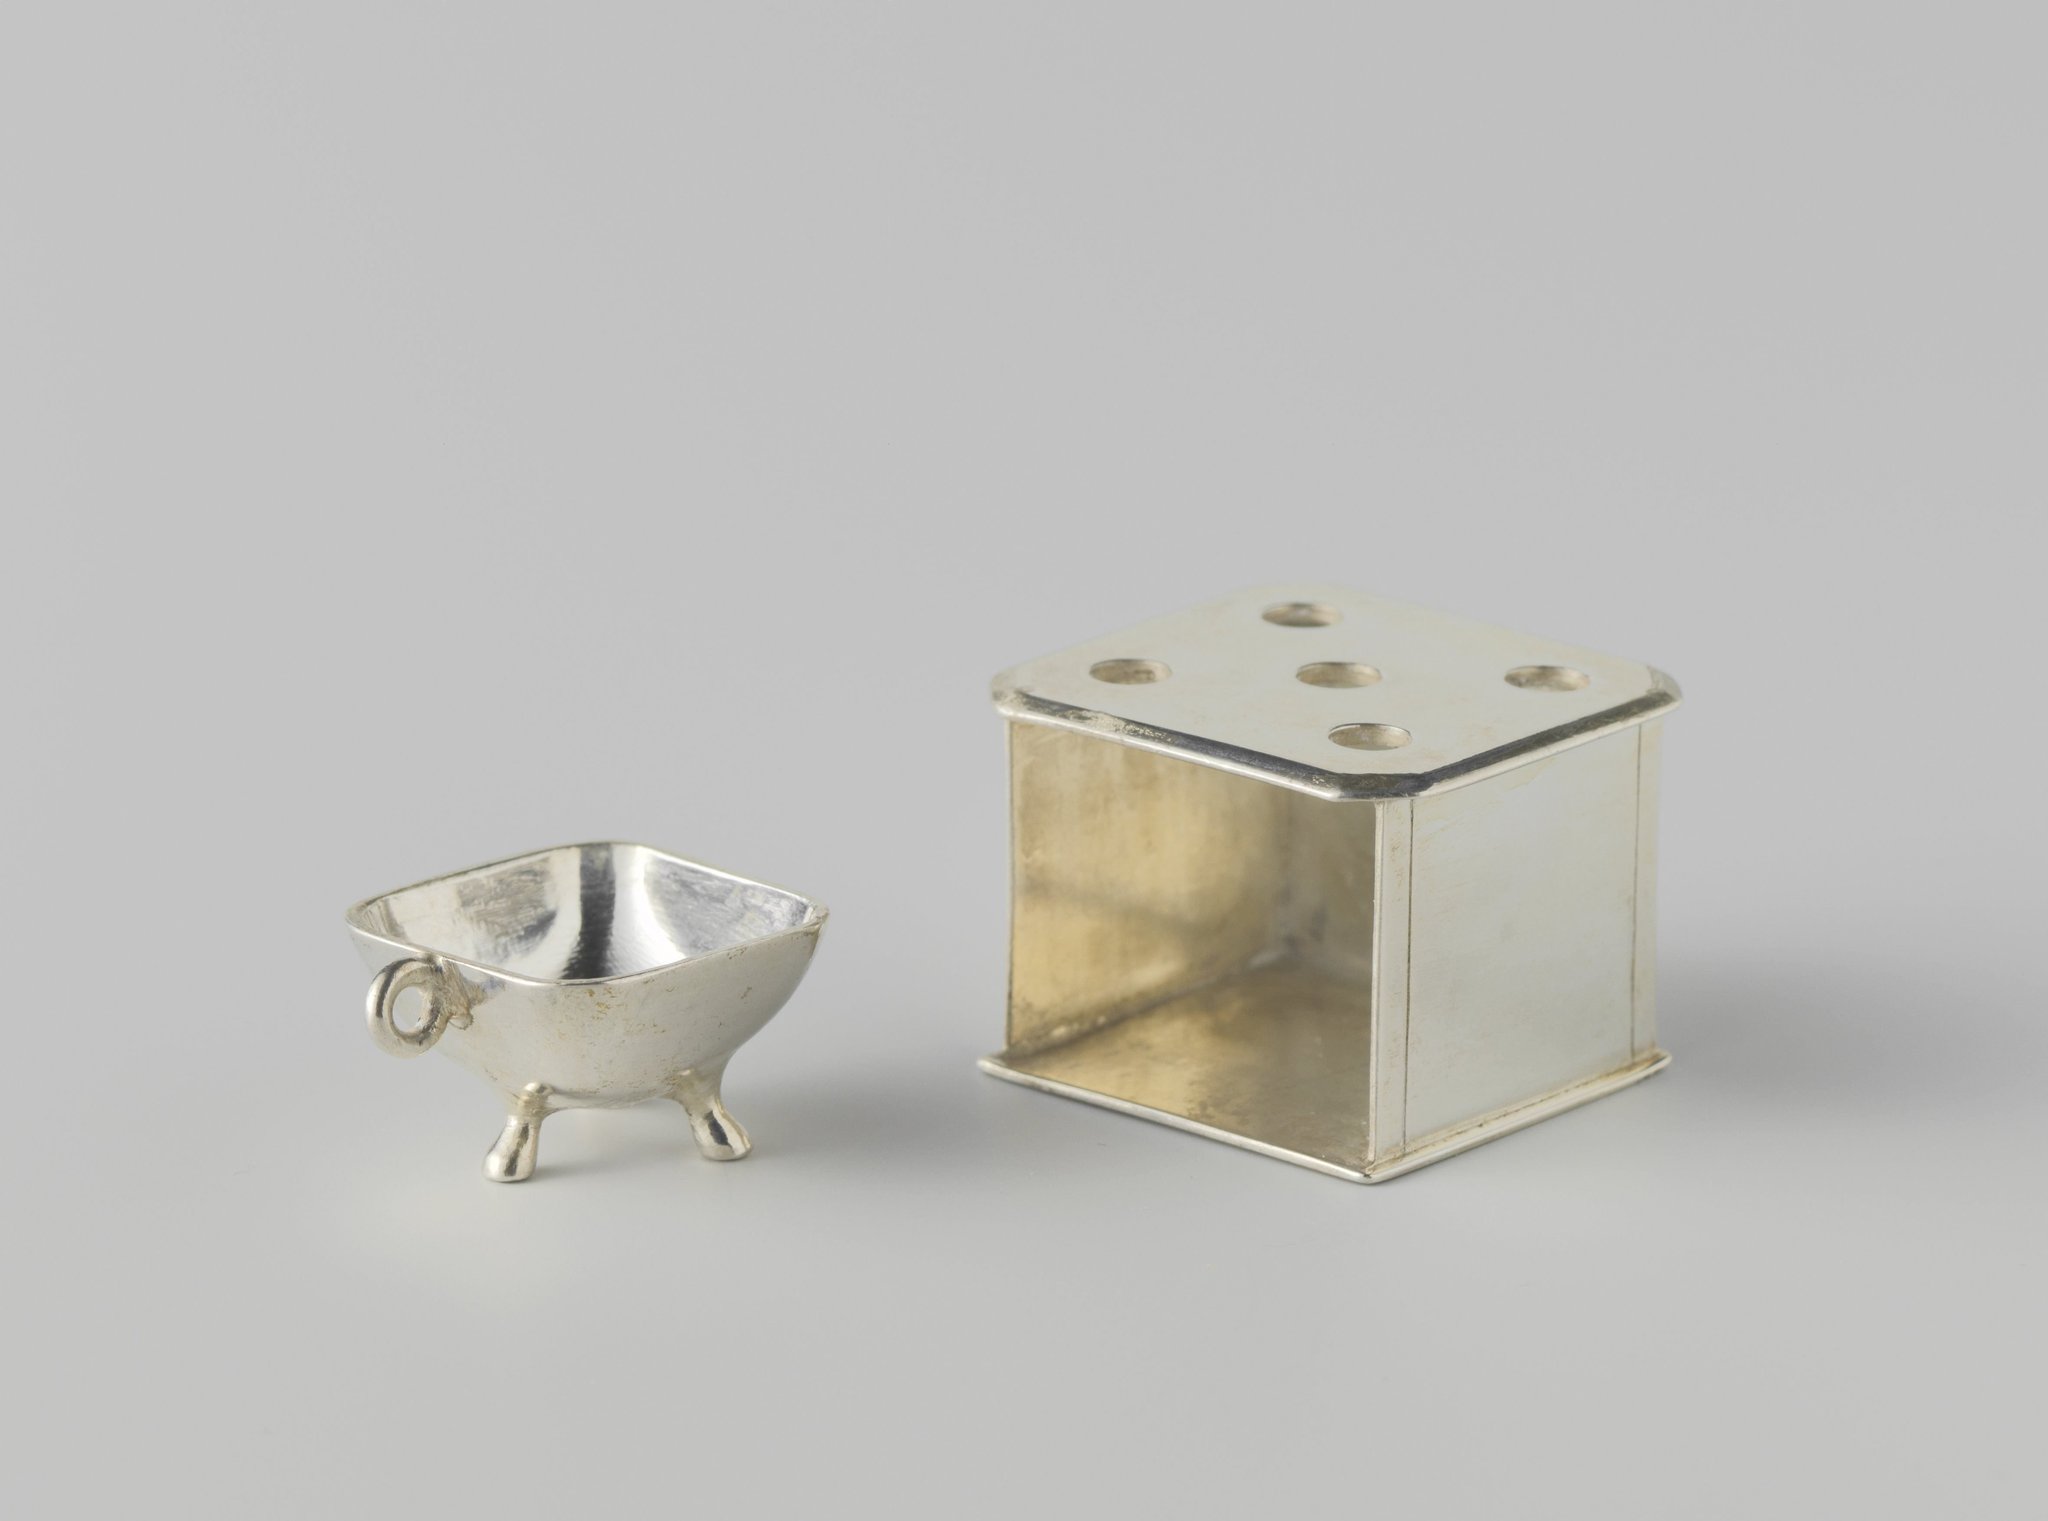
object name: miniature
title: Vierkante vuurtest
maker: willem van strant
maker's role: silversmith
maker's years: 1682-1742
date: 1727-1742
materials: silver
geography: amsterdam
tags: foot-stove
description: Test op drie poten en een oor. De bovenkant van de test is vierkant en loopt naar onderen rond en smal toe. De test staat in een bijbehorende stoof (BK-NM-11177-163-a).